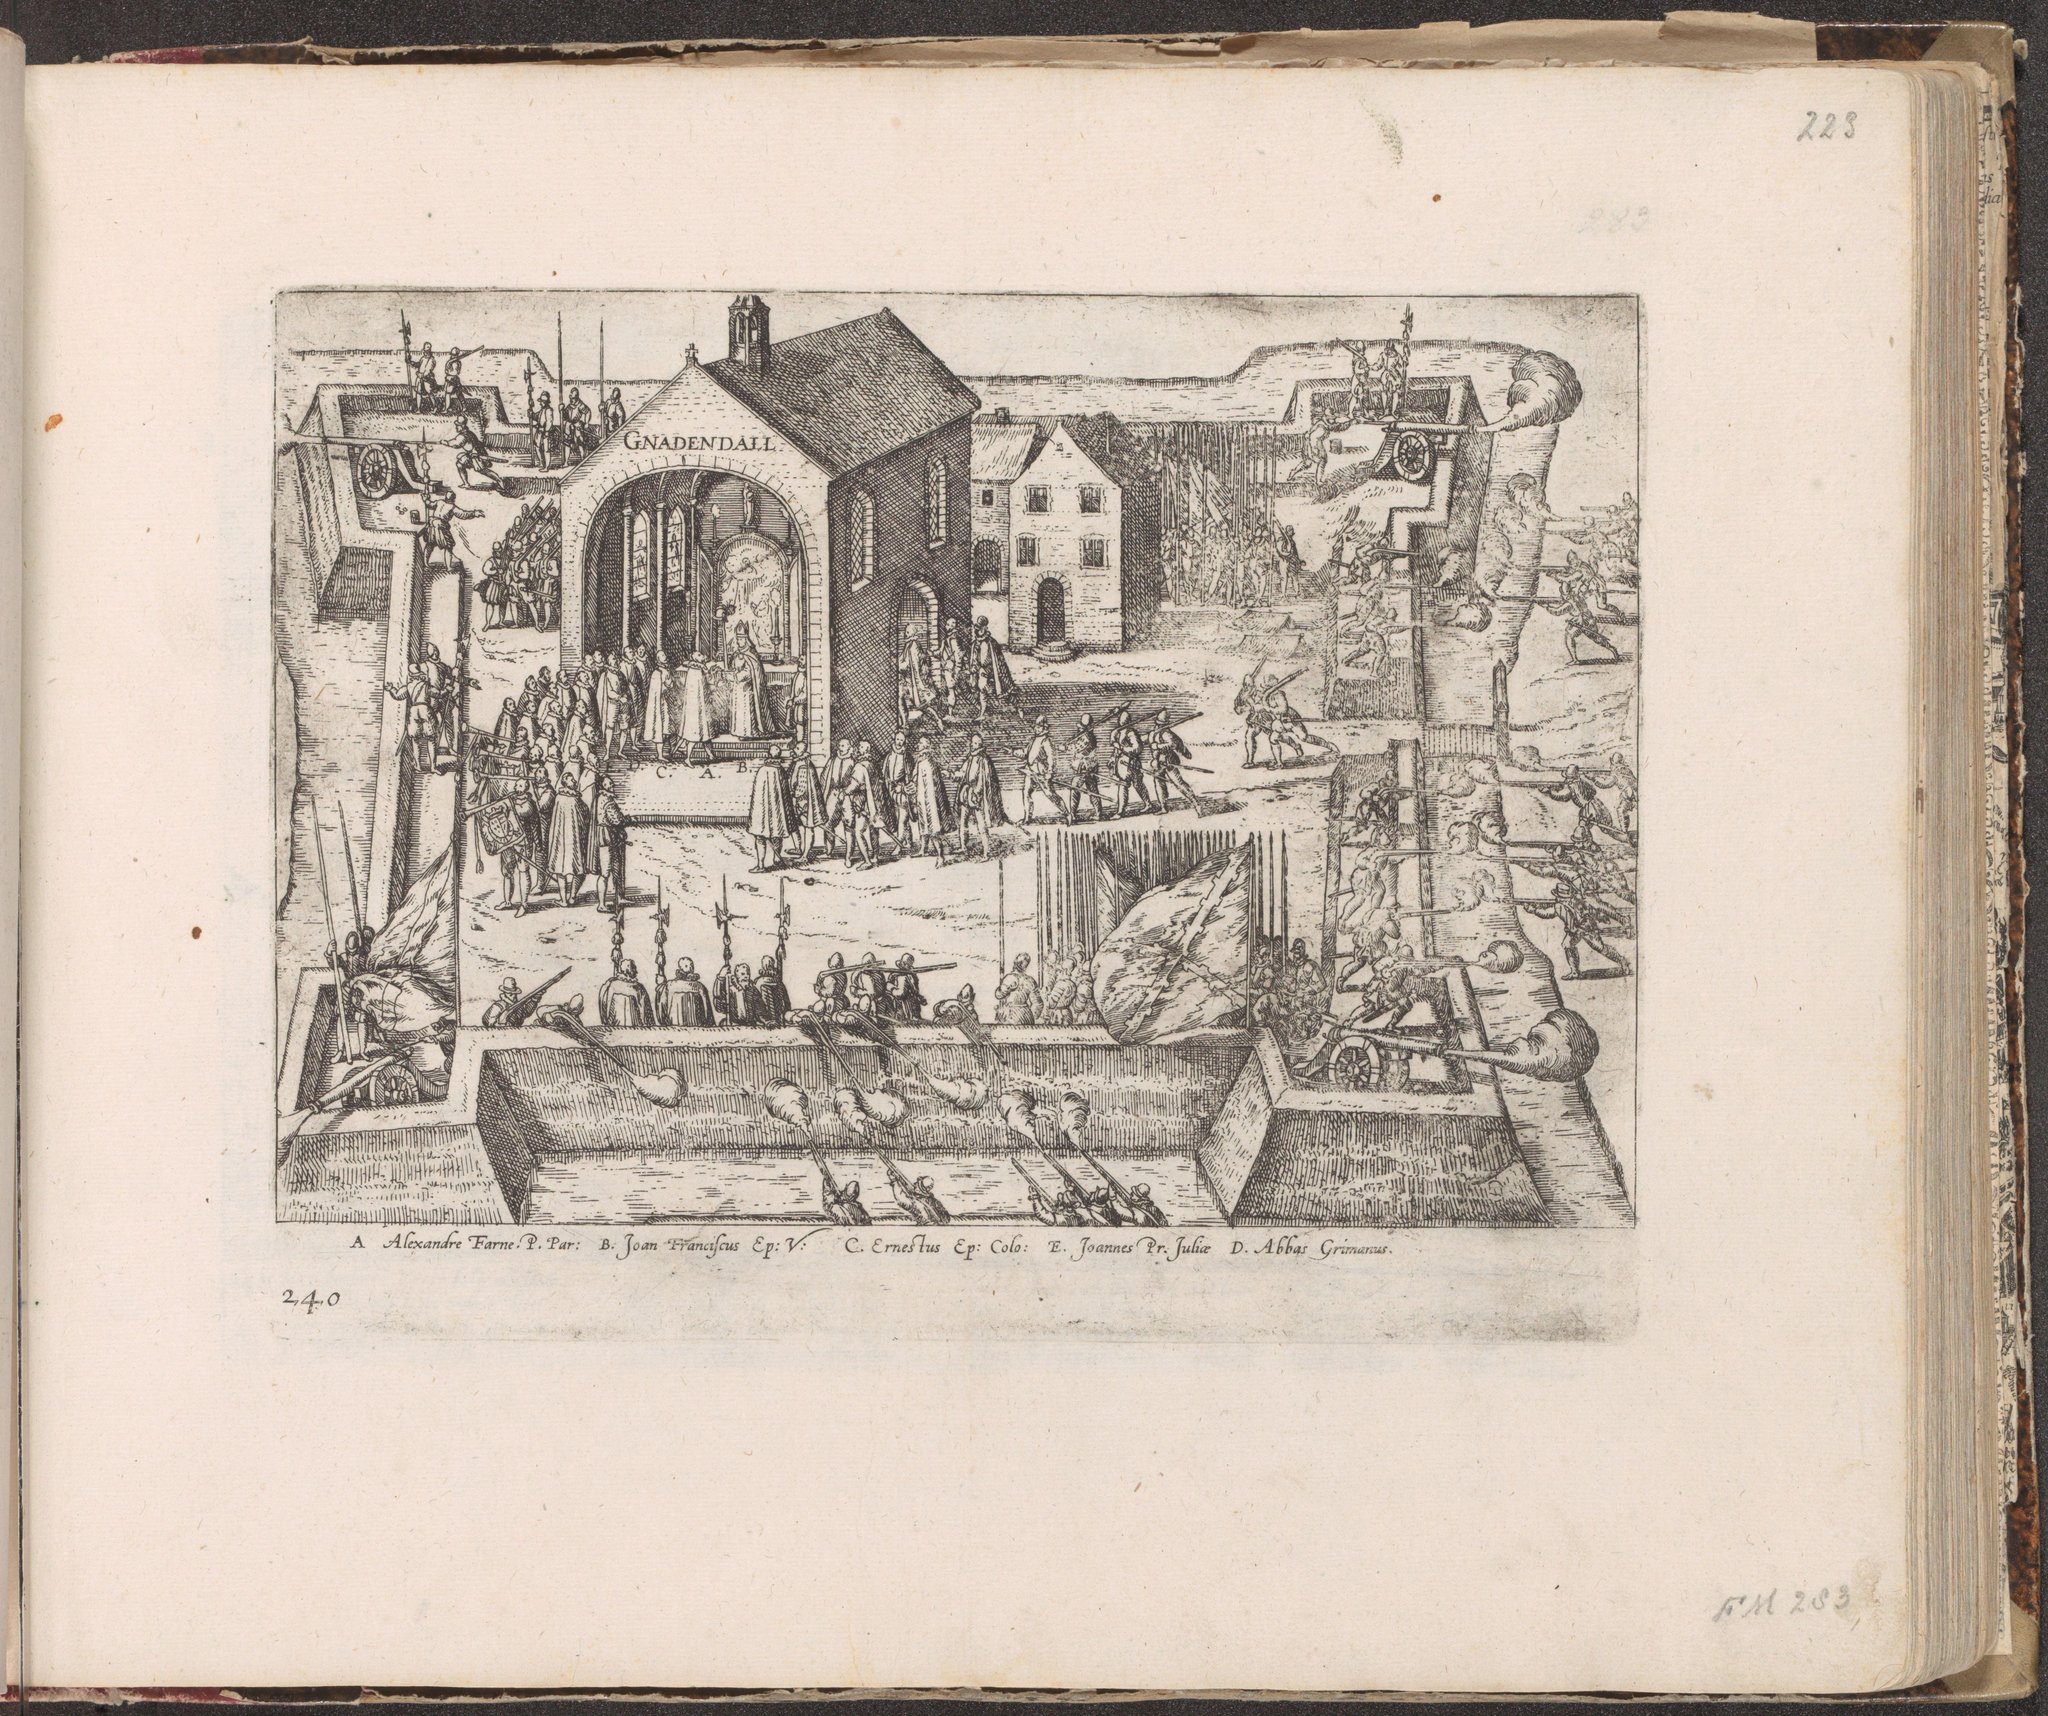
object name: history print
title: Serie 9: Nederlandse en Duitse Gebeurtenissen, 1583-1587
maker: frans hogenberg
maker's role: print maker, publisher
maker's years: 1538-1590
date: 1587-1591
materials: paper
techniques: etching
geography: cologne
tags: rome, alessandro farnese (landvoogd van de nederlanden en hertog van parma en piacenza)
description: De hertog van Parma wordt door de pauselijke afgezant geprezen voor zijn verdiensten, scène in een kerk te Gnadental bij Neuss, 1 augustus 1586. Episode uit de Keulse Oorlog. Met als onderschrift in de plaat alleen de verklaring van de letters A-D. Linksonder genummerd: 240. De prent maakt deel uit van een album.